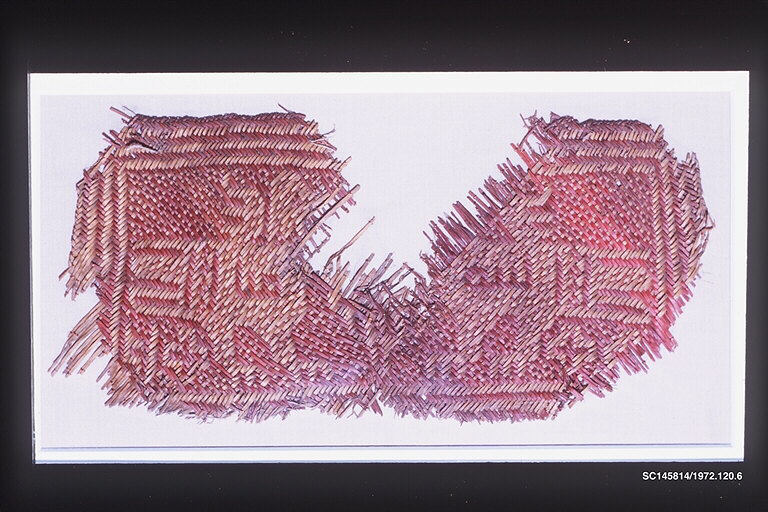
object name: fan fragment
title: Fragment of a Fan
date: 901-1000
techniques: weave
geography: egypt or syria